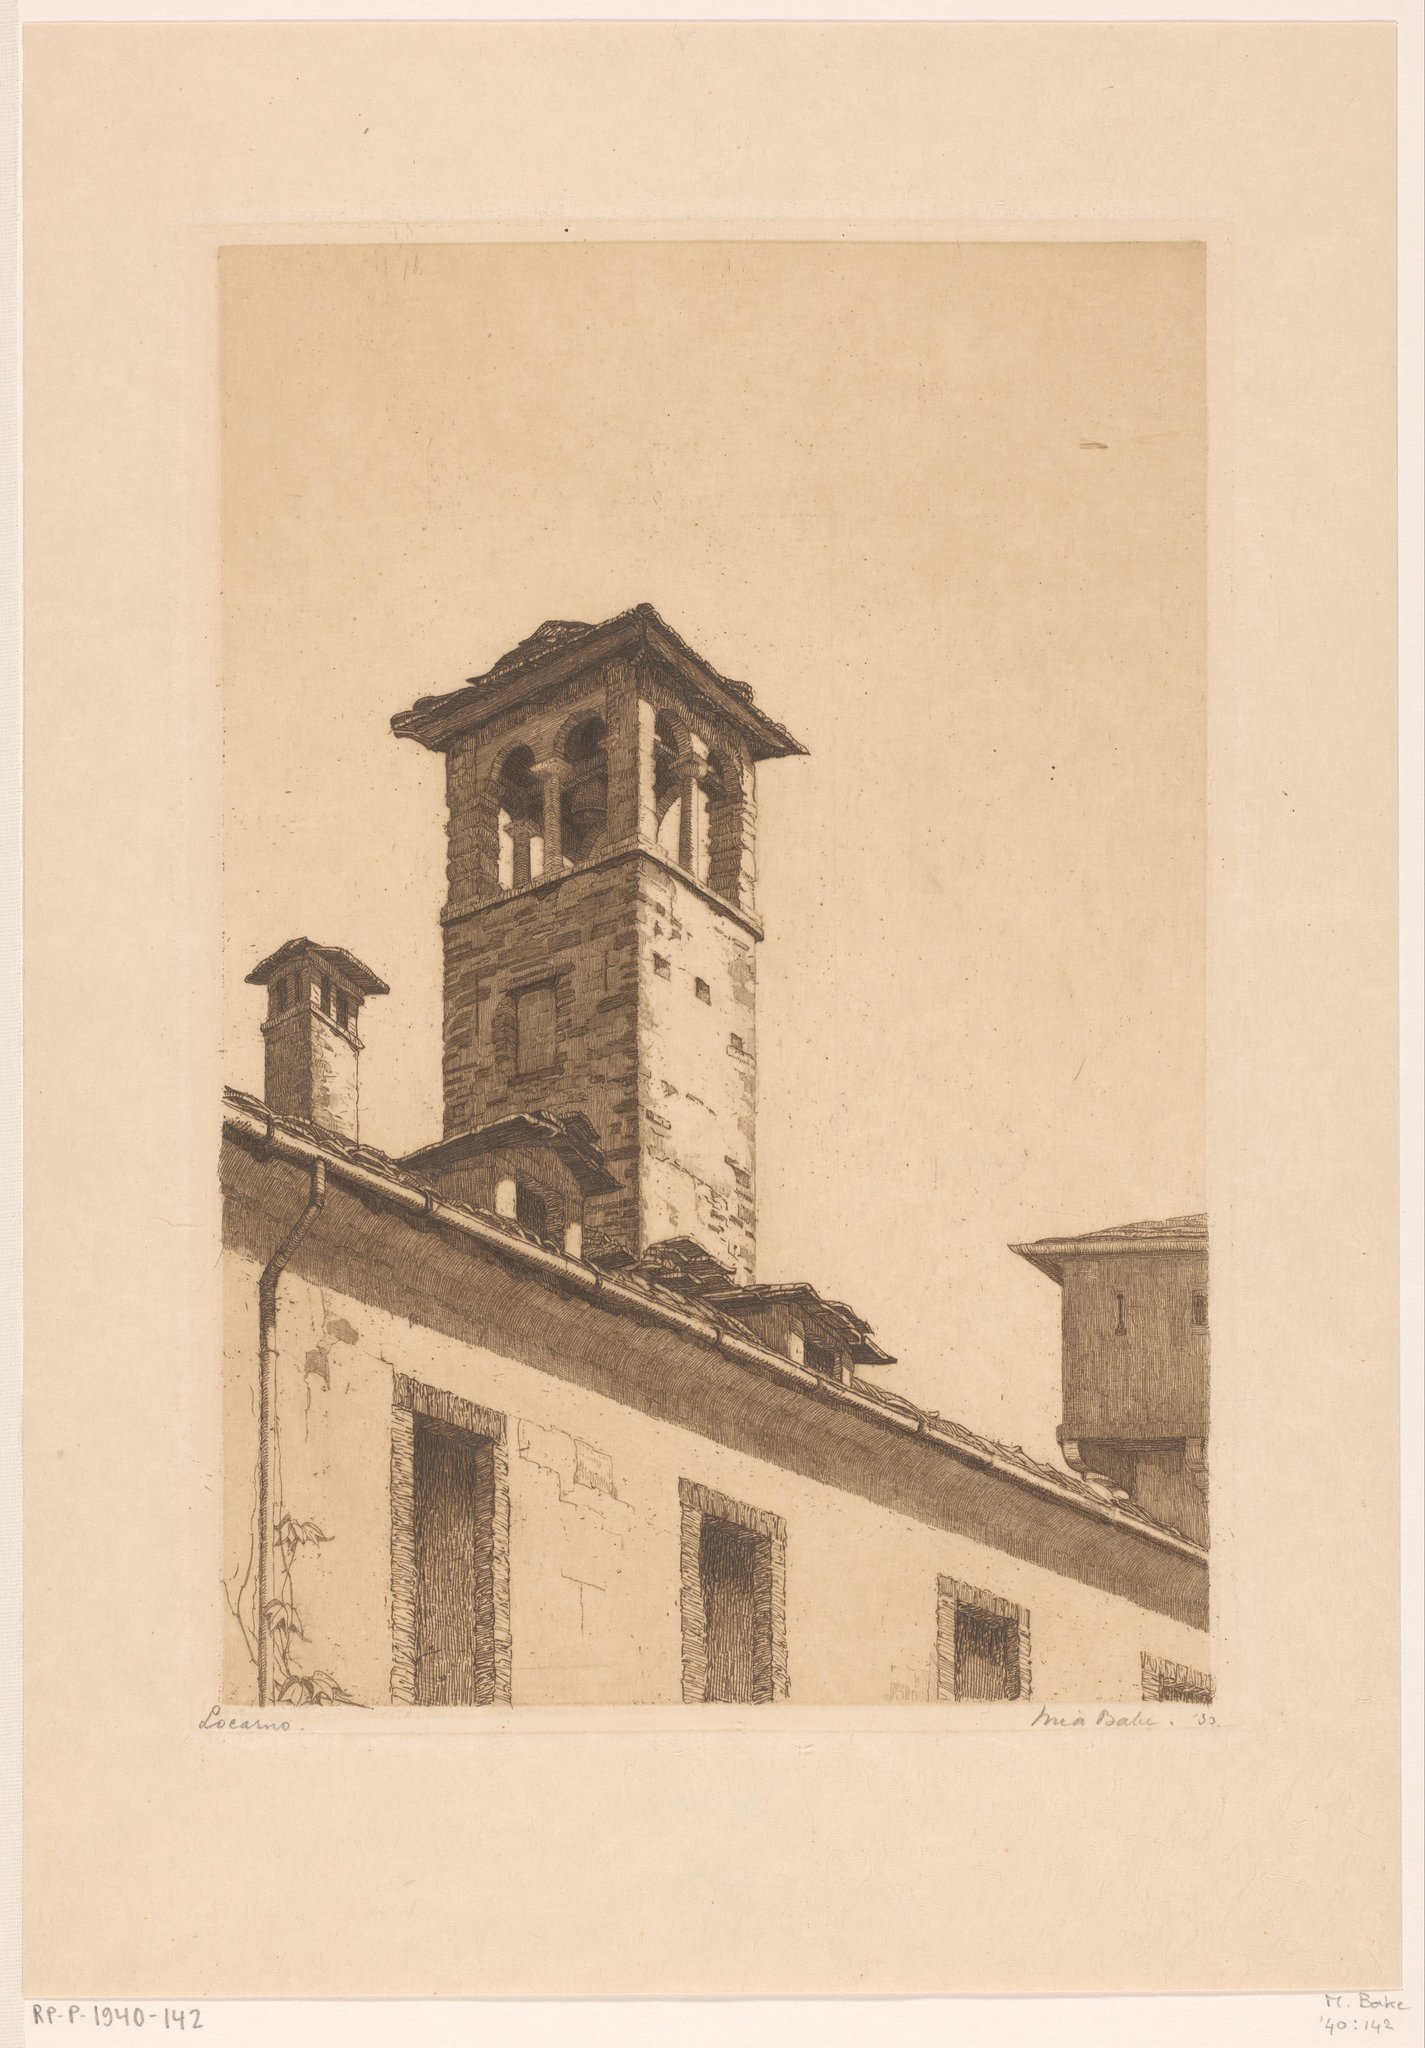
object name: print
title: Locarno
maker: mia bake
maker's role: draughtsman, print maker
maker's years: 1886-1939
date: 1933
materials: paper, ink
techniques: aquatint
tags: tower, clock tower ~ monumental adornment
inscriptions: signature and date: ‘Mia Bake ´33’, collector's mark: Lugt L.2166, title: ‘Locarno’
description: Gezicht op de bovenkant van een gebouw met een stenen klokkentoren.